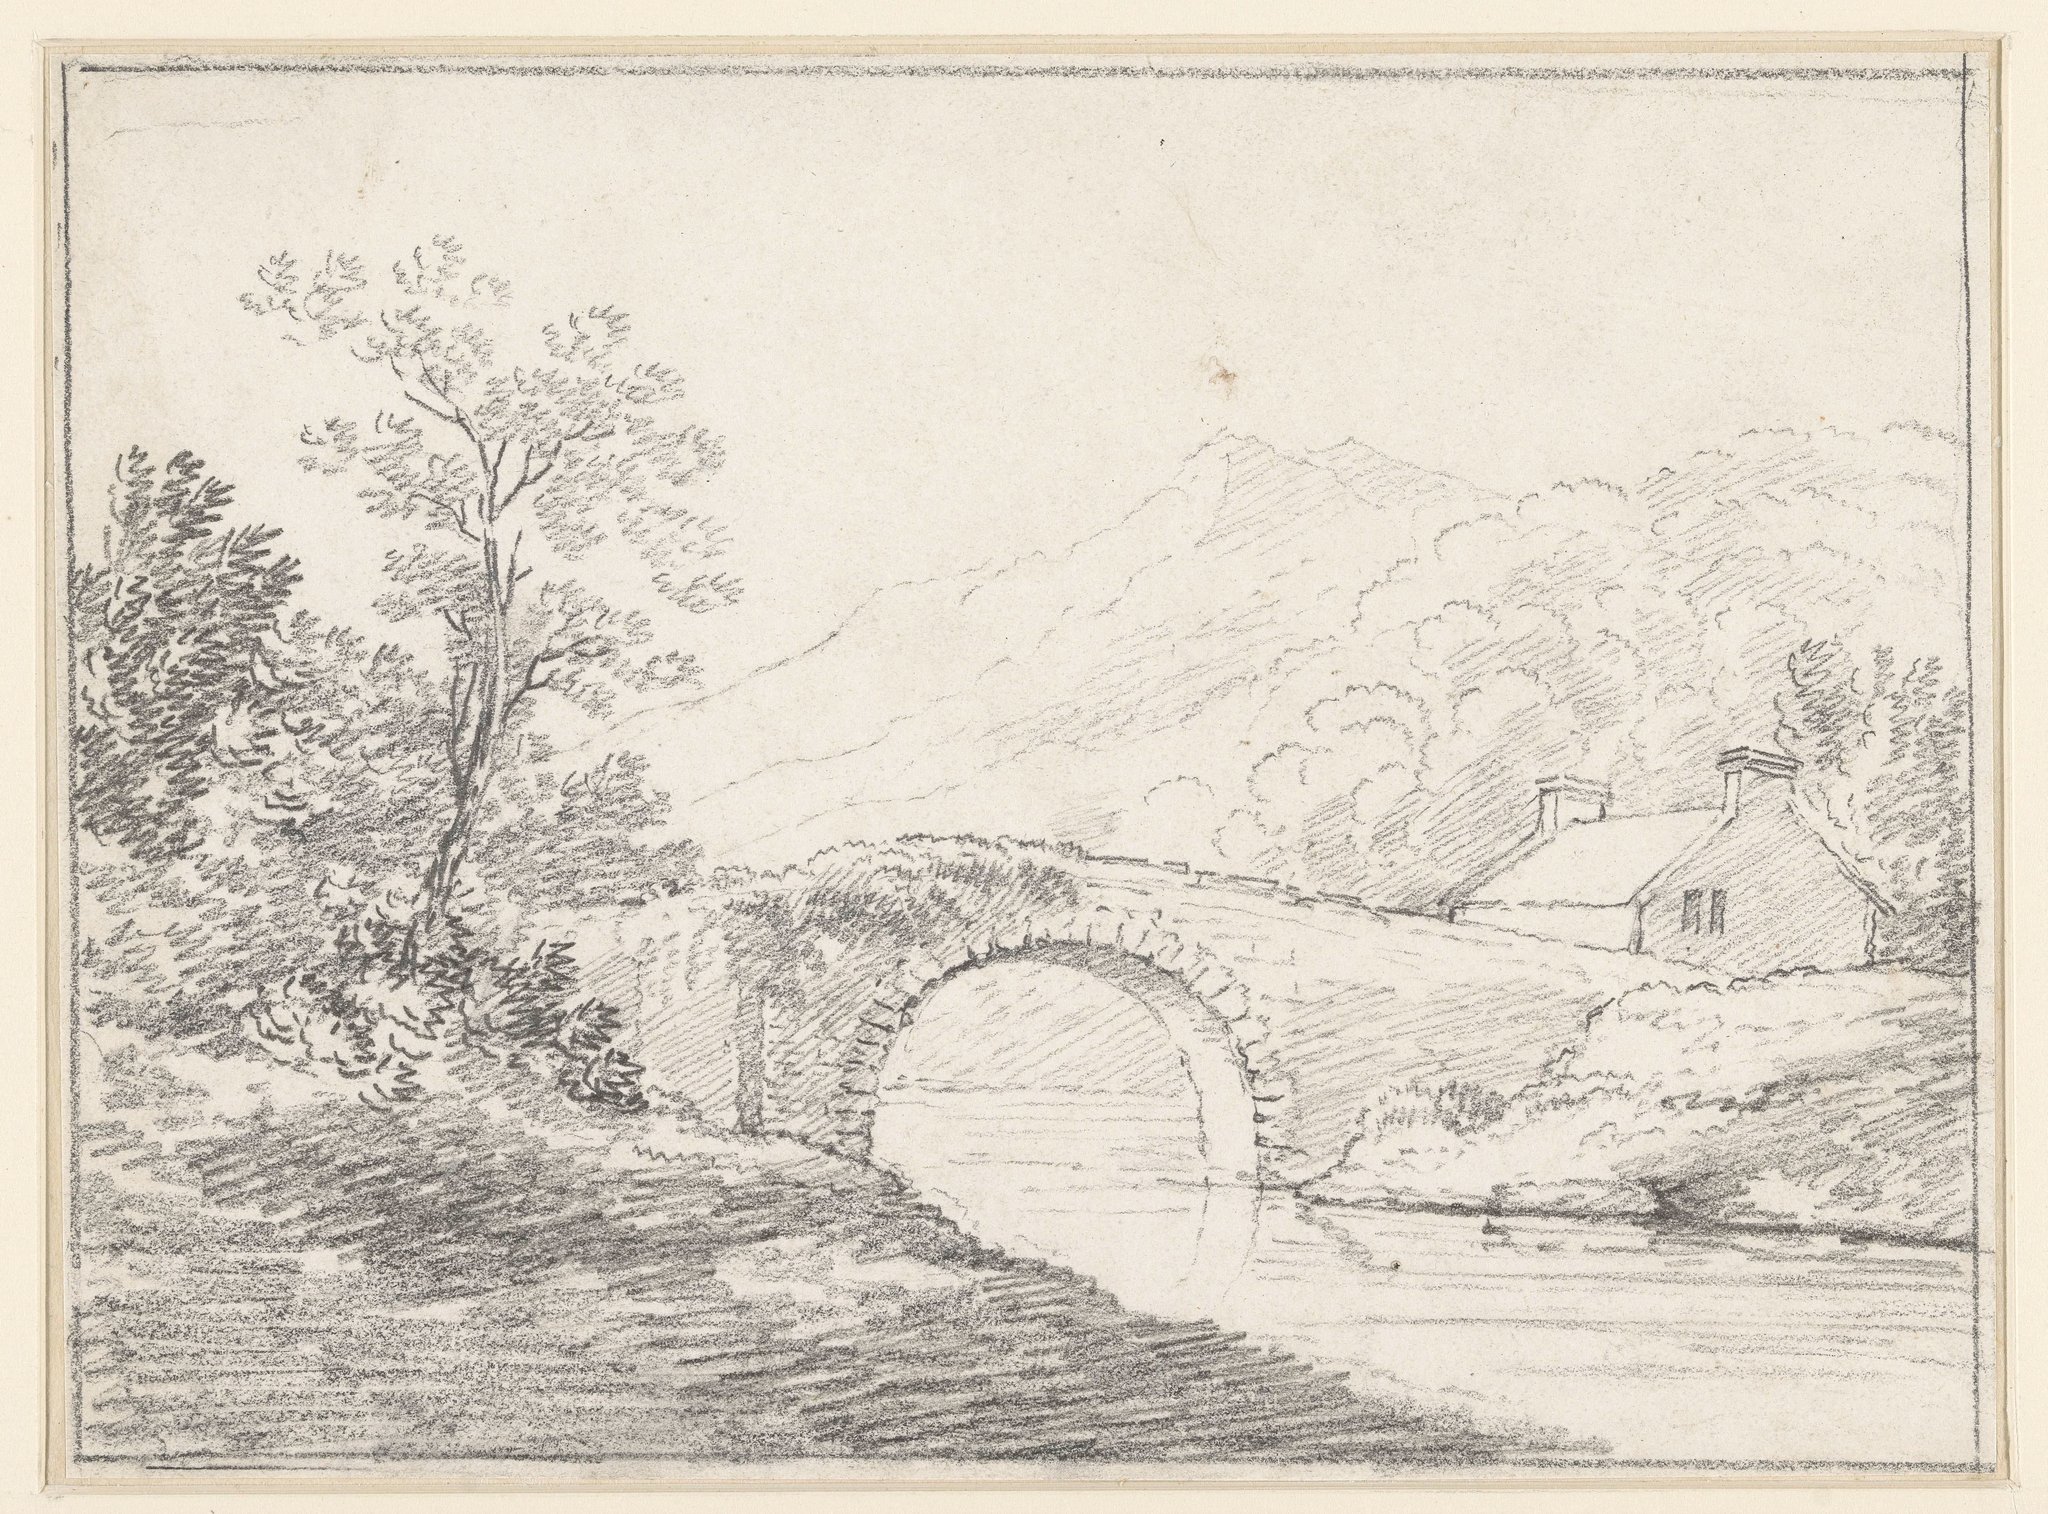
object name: drawing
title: Landschap met stenen brug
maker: frederik hendrik weissenbruch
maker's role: draughtsman, print maker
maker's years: 1828-1887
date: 1838-1887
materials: paper, pencil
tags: bridge